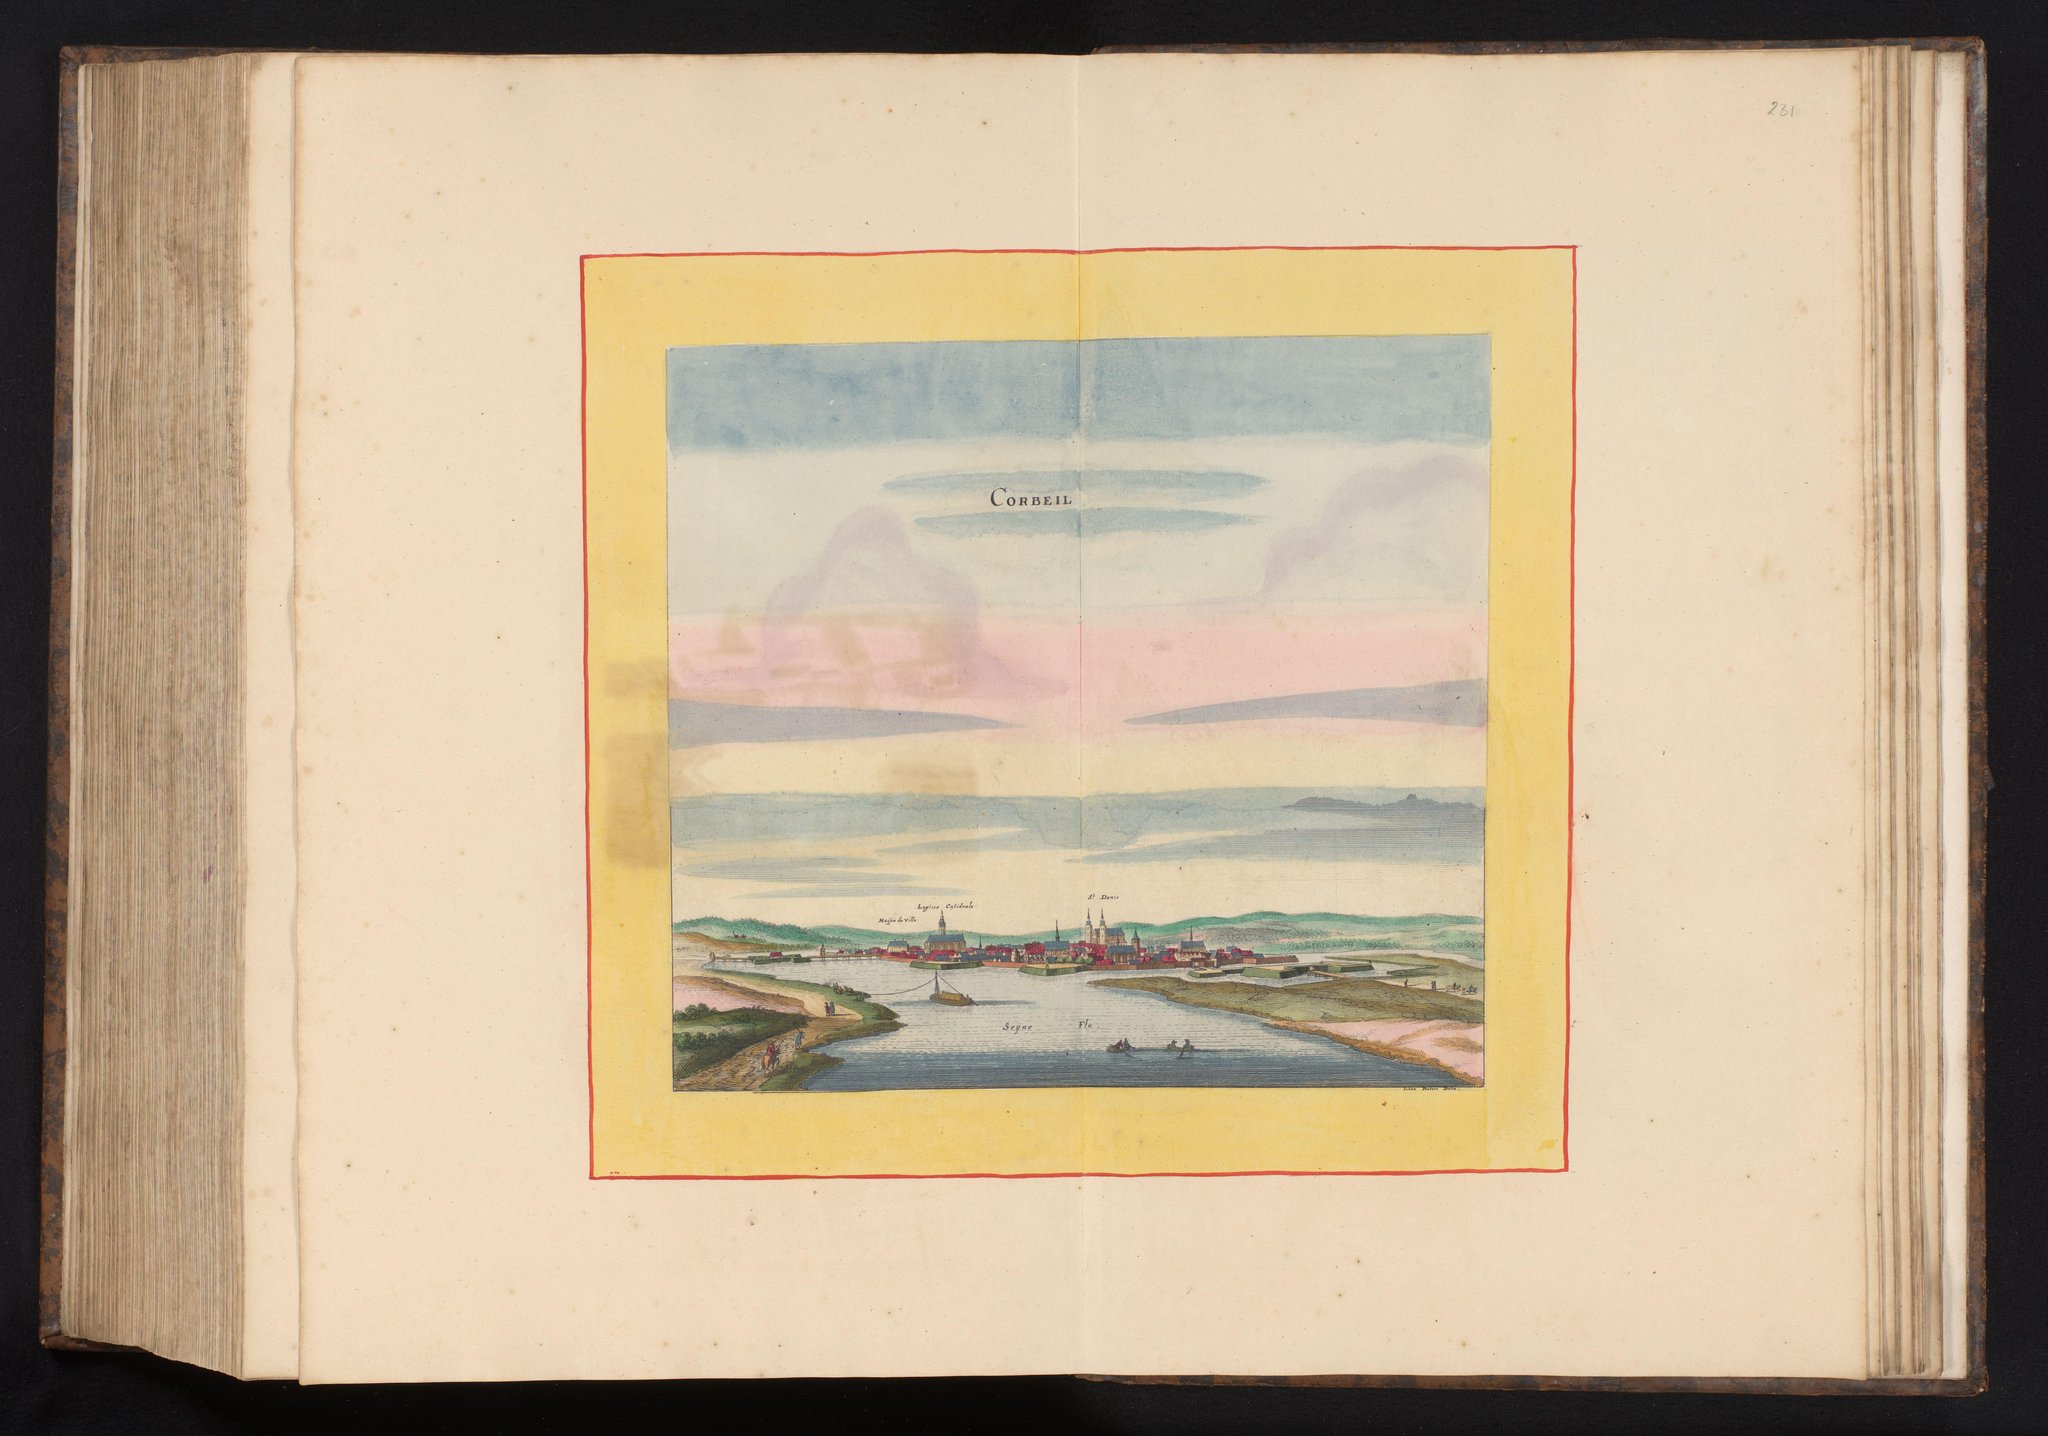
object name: print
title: Corbeil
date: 1655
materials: paper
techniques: engraving, etching, hand coloring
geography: the hague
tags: city-view in general; 'veduta', river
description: Prent origineel vervaardigd als boekillustratie voor: Zeiller, Martin. Topographia Galliae, oder Beschreibung und Contrafaitung der vornehmbsten und bekantisten Oerter in dem mächtigen und grossen Königreich Frankreich, 13 delen. Frankfurt am Main: Caspar Merian, 1655-1661. De prent werd voor het eerst gepubliceerd in deel 1: Topographia Galliae, 1655. De prent is langs de bovenrand van de voorstelling afgescheurd. De titel is hoger opgeplakt. De voorstelling is aan de bovenzijde aangevuld met een geschilderde lucht.